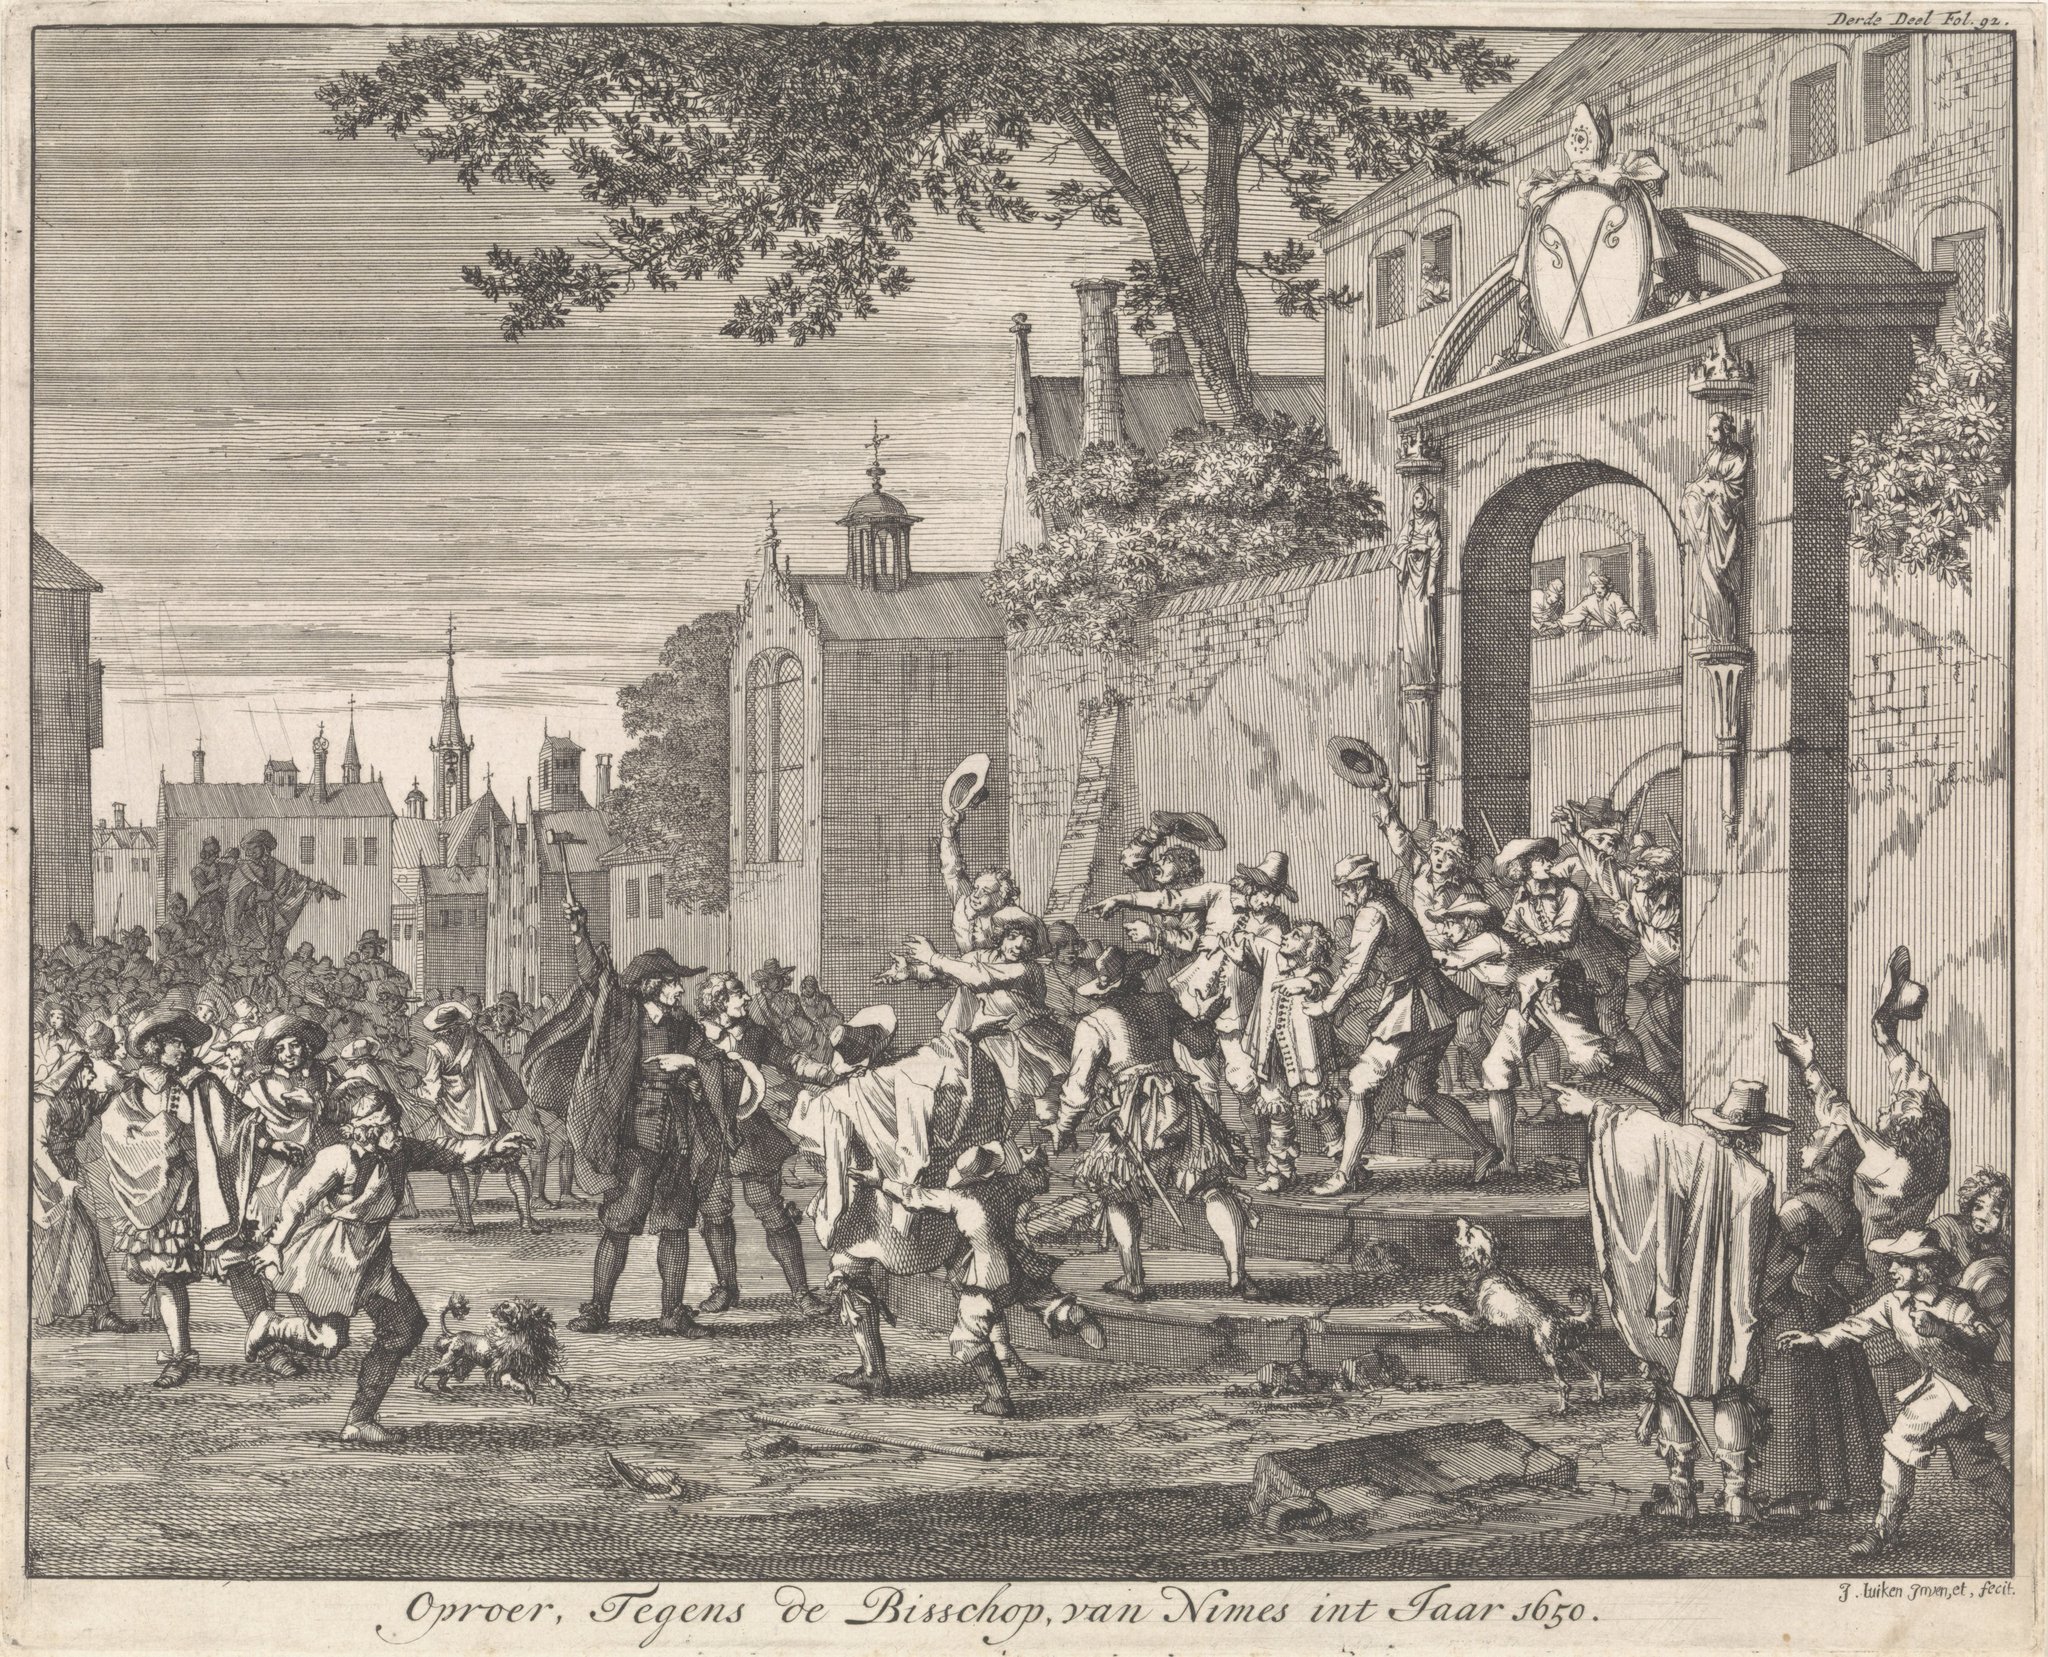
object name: print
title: Oproer, Tegens de Bisschop van Nimes int Jaar 1650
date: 1696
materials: paper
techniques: etching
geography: amsterdam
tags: street-fights, riots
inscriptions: collector's mark: Lugt 2228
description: Illustratie uit: Benoist, Elie. Historie der gereformeerde kerken van Vrankryk, 4 delen. Amsterdam: Jan Claesz ten Hoorn, 1696, dl. III.